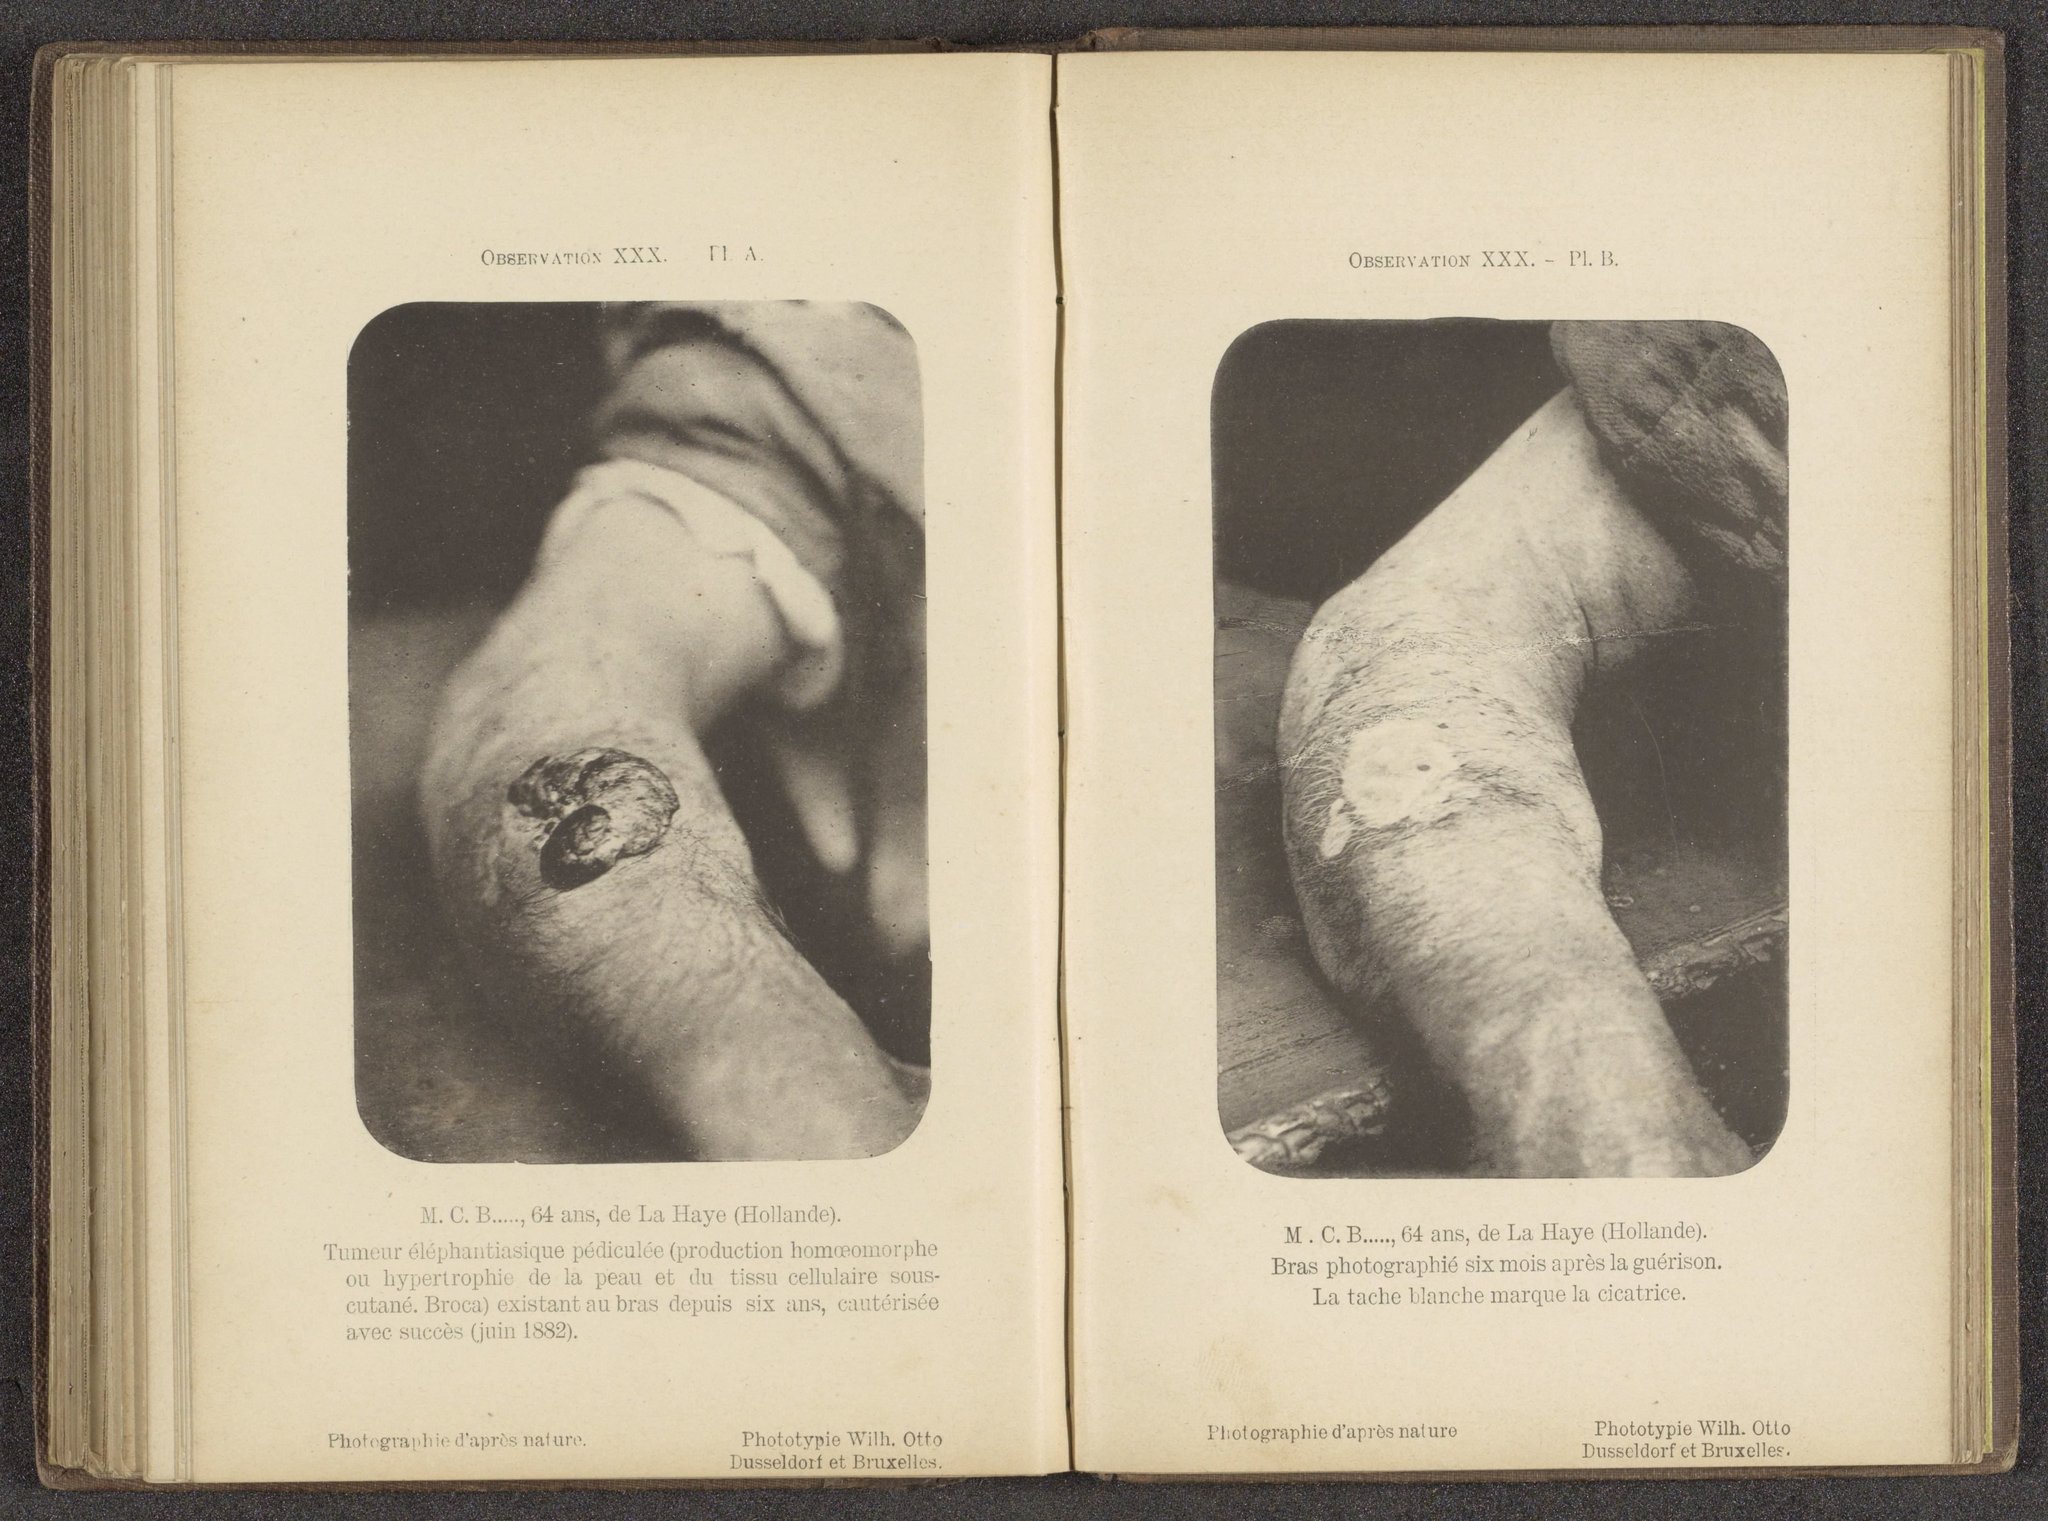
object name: page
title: Arm met een litteken na het verwijderen van een tumor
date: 1874-1884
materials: paper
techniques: photograph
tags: scar, cicatrix, tumours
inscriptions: inscription: ‘Observation XXX. - Pl. B. / M. C. B...., 64 ans, de la Haye (Hollande). / Bras photographié six mois après la guérison. (...)’